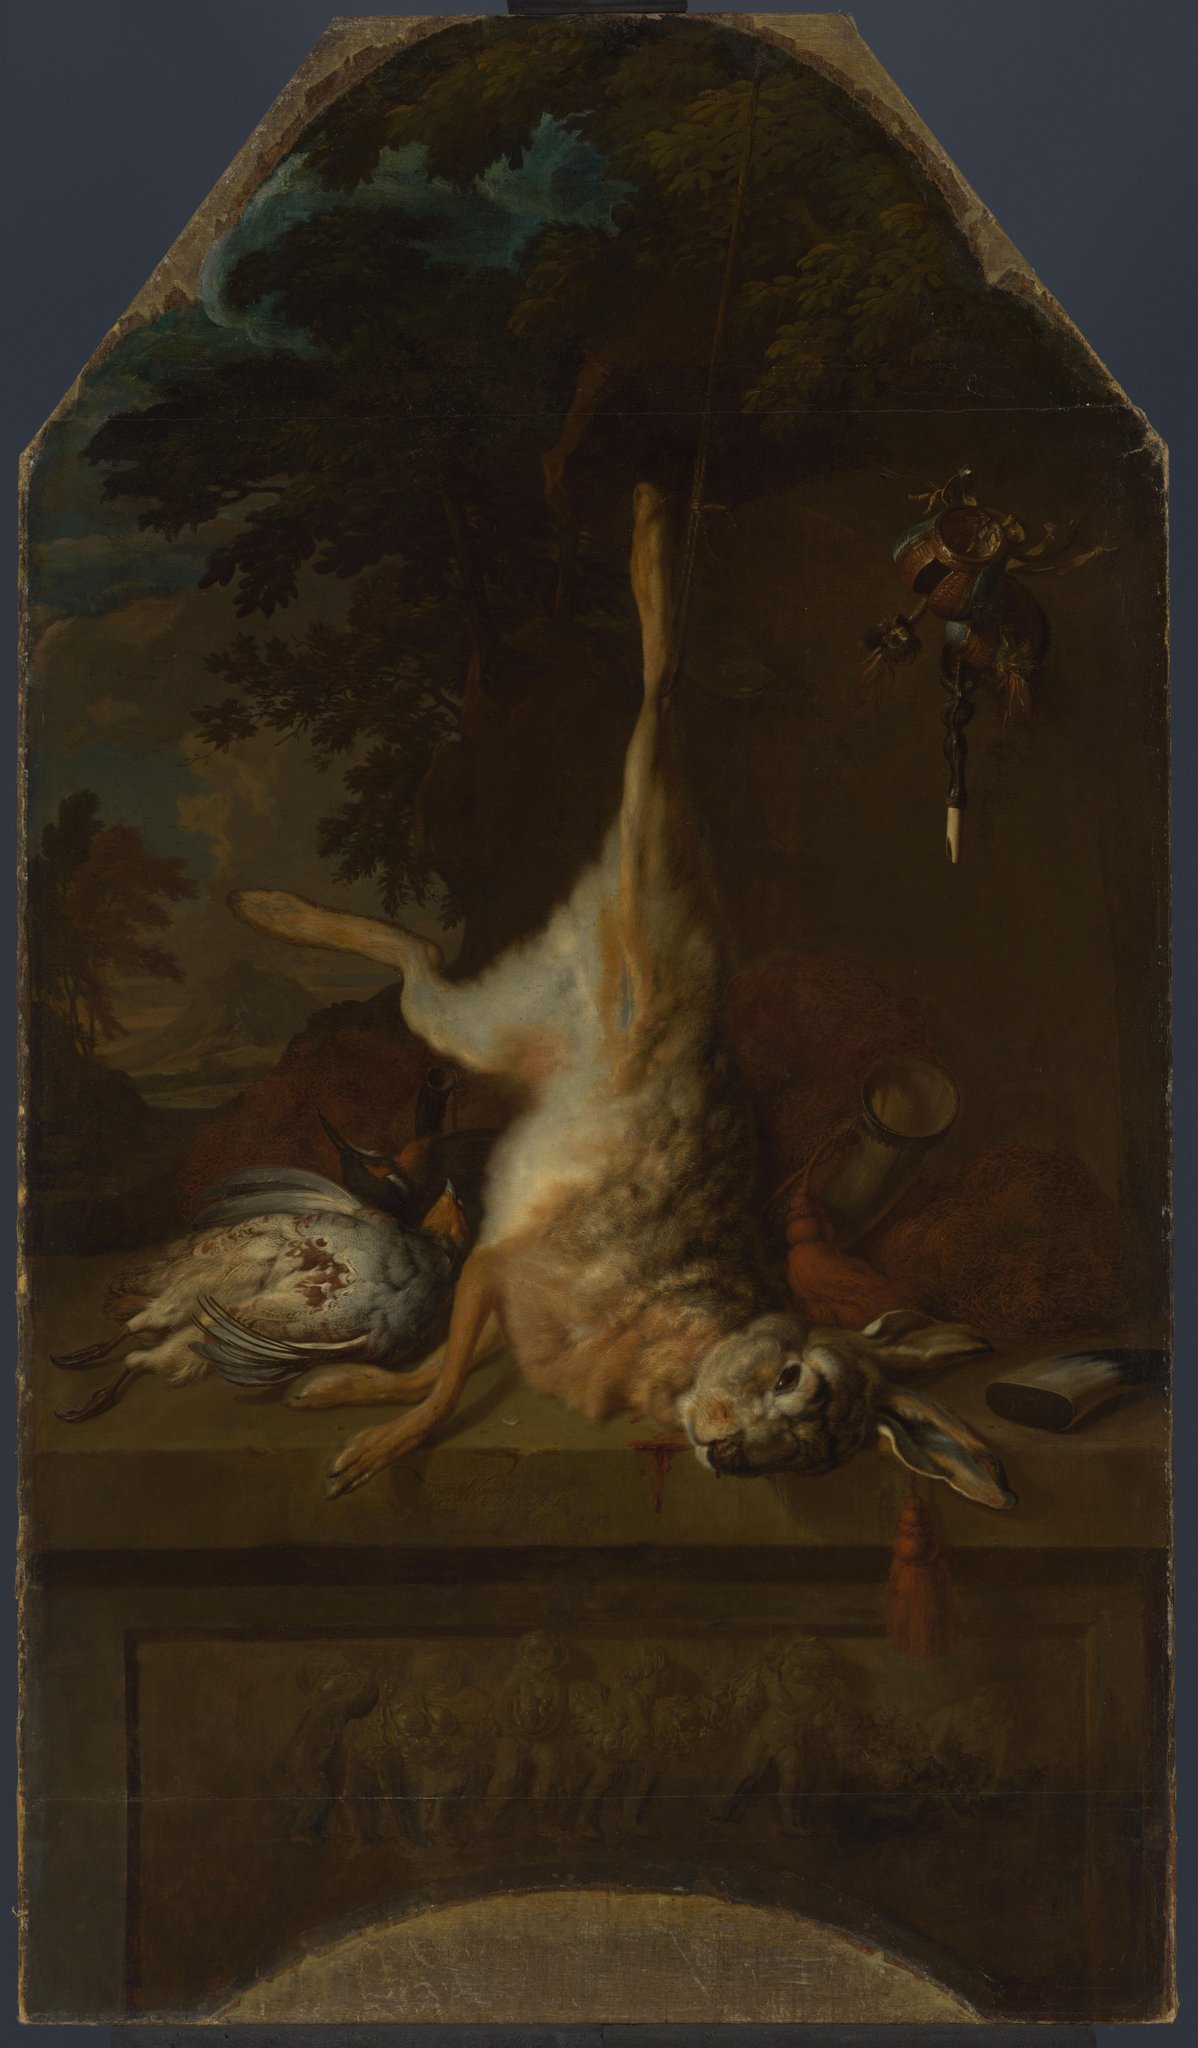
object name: painting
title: Still Life with Dead Hare and Partridges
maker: dirk valkenburg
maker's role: draughtsman, painter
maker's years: 1675-1721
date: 1717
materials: canvas, oil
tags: still life of related objects, rodents: hare (+ animal killed by man), hunting trophies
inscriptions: signature and date: ‘Valkenburg 1717’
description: Schouwstuk met een stilleven met een dode haas opgehangen aan een poot, een paar patrijzen, een jachthoorn en enkele andere attributen van de jacht op een stenen plint. Onderaan de plint een reliëf van putti met een festoen van bloemen en vruchten. Op de achtergrond een landschap.